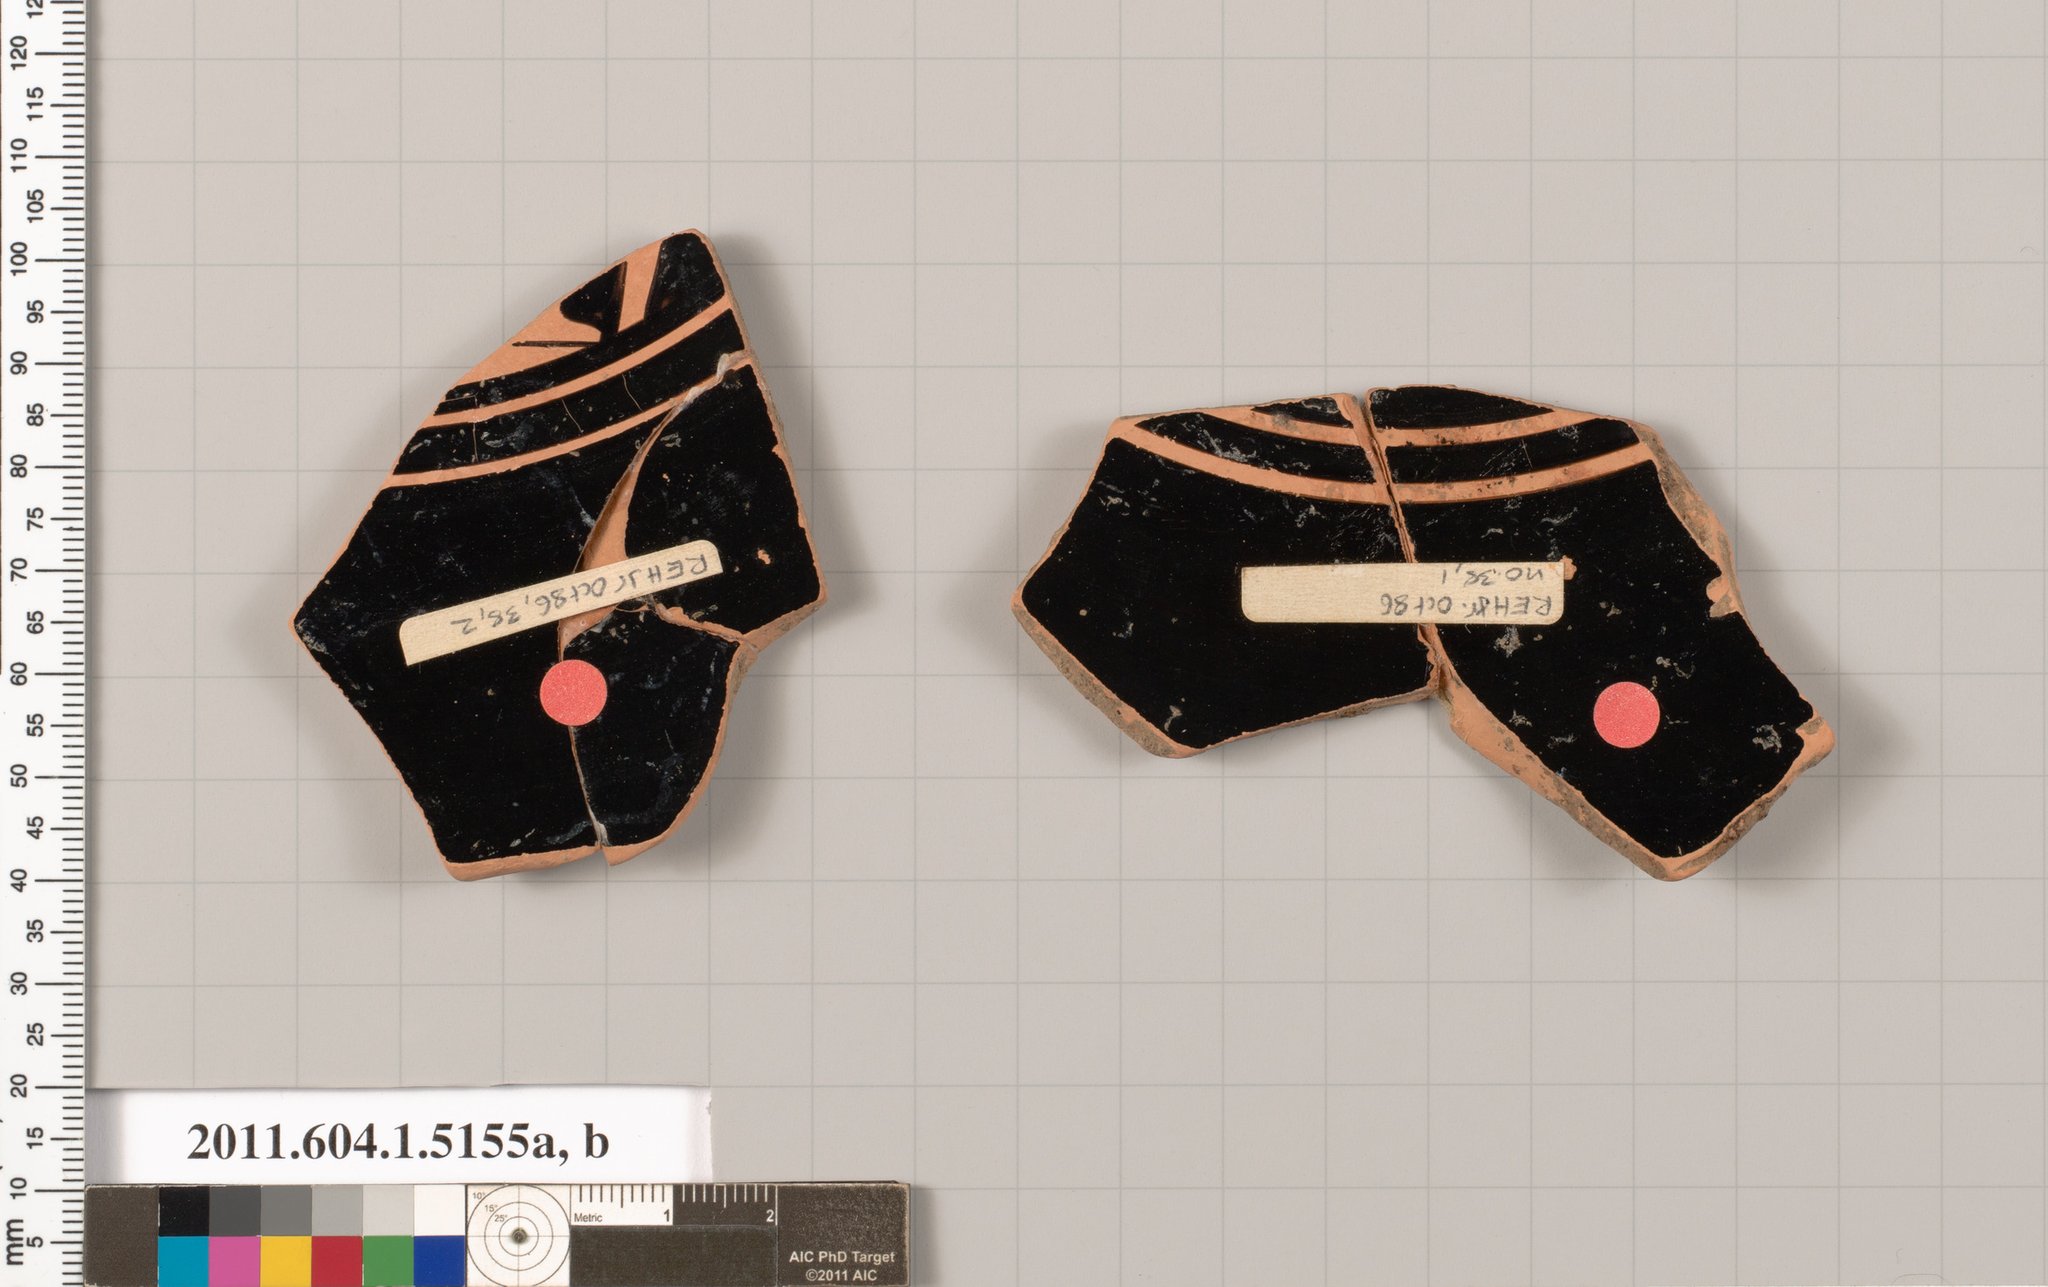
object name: kylix fragment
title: Terracotta fragments of a kylix (drinking cup)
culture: greek, attic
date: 500-480 BCE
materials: terracotta